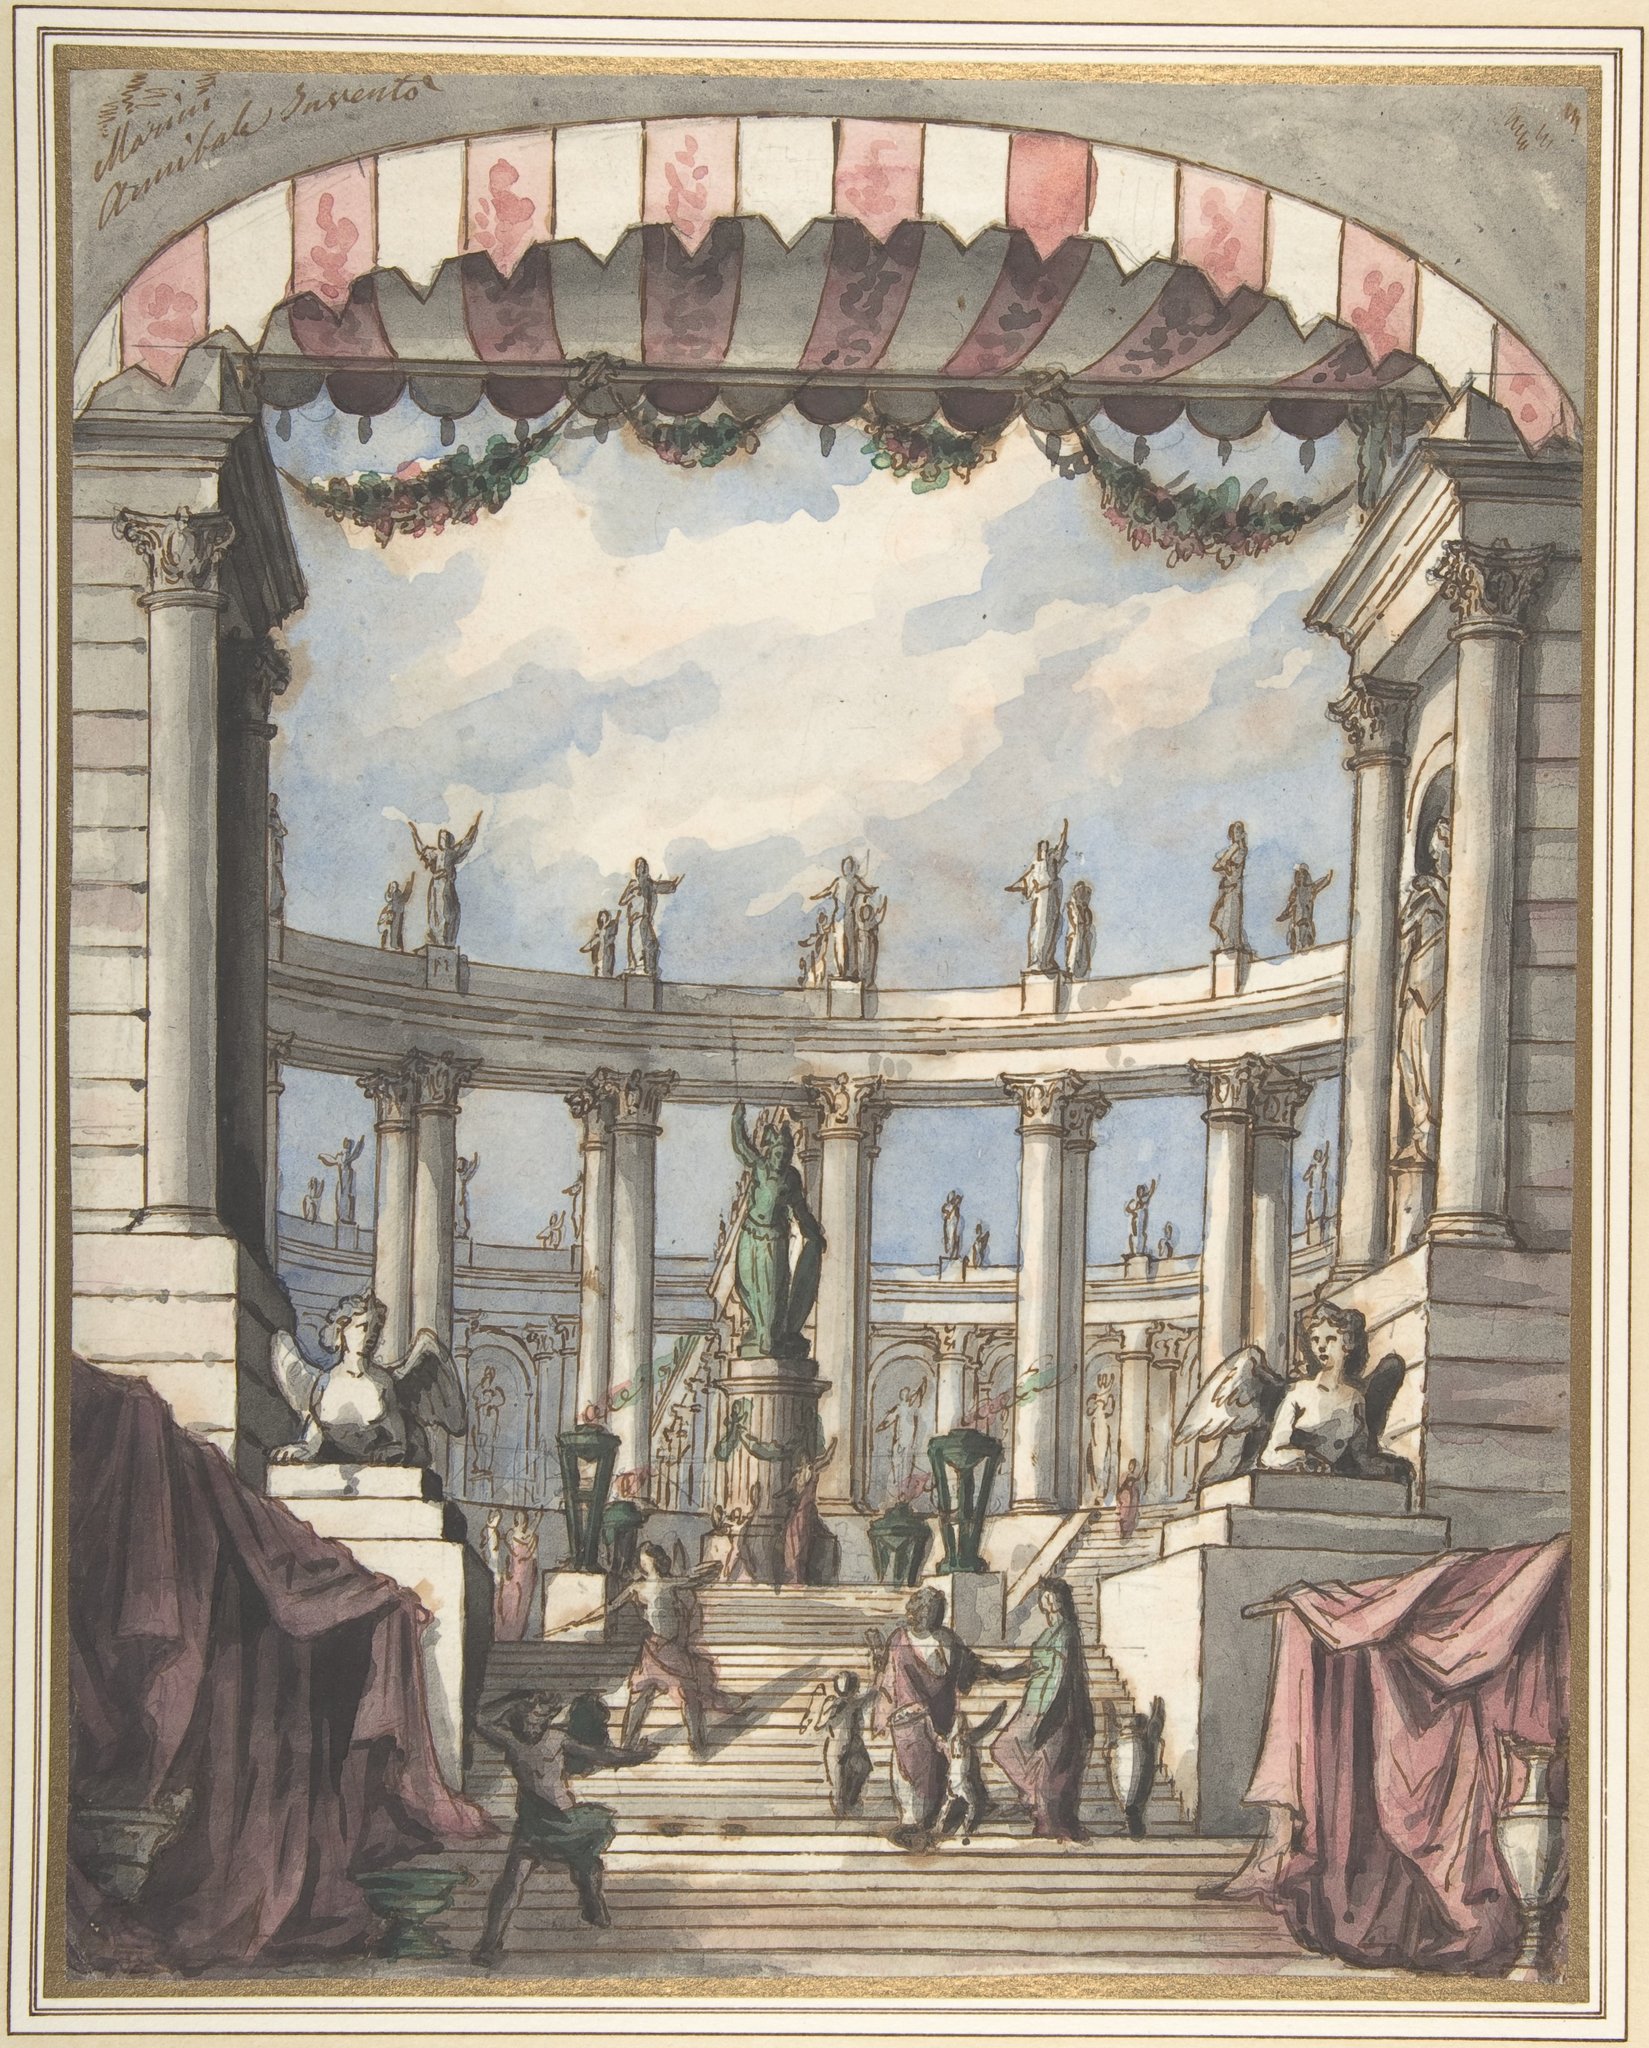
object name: drawing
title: Design for a Stage Set: A Classical Courtyard and Colonnade with a Statue of Minerva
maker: leonardo marini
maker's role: artist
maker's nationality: italian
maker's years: 1730-1797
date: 1780-1790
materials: graphite, ink, paper, lead, watercolor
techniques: brush, pen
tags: minerva,stage design